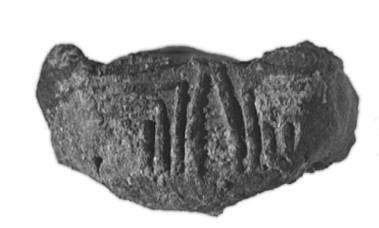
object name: sealing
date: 2030-1640 BCE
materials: clay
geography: egypt